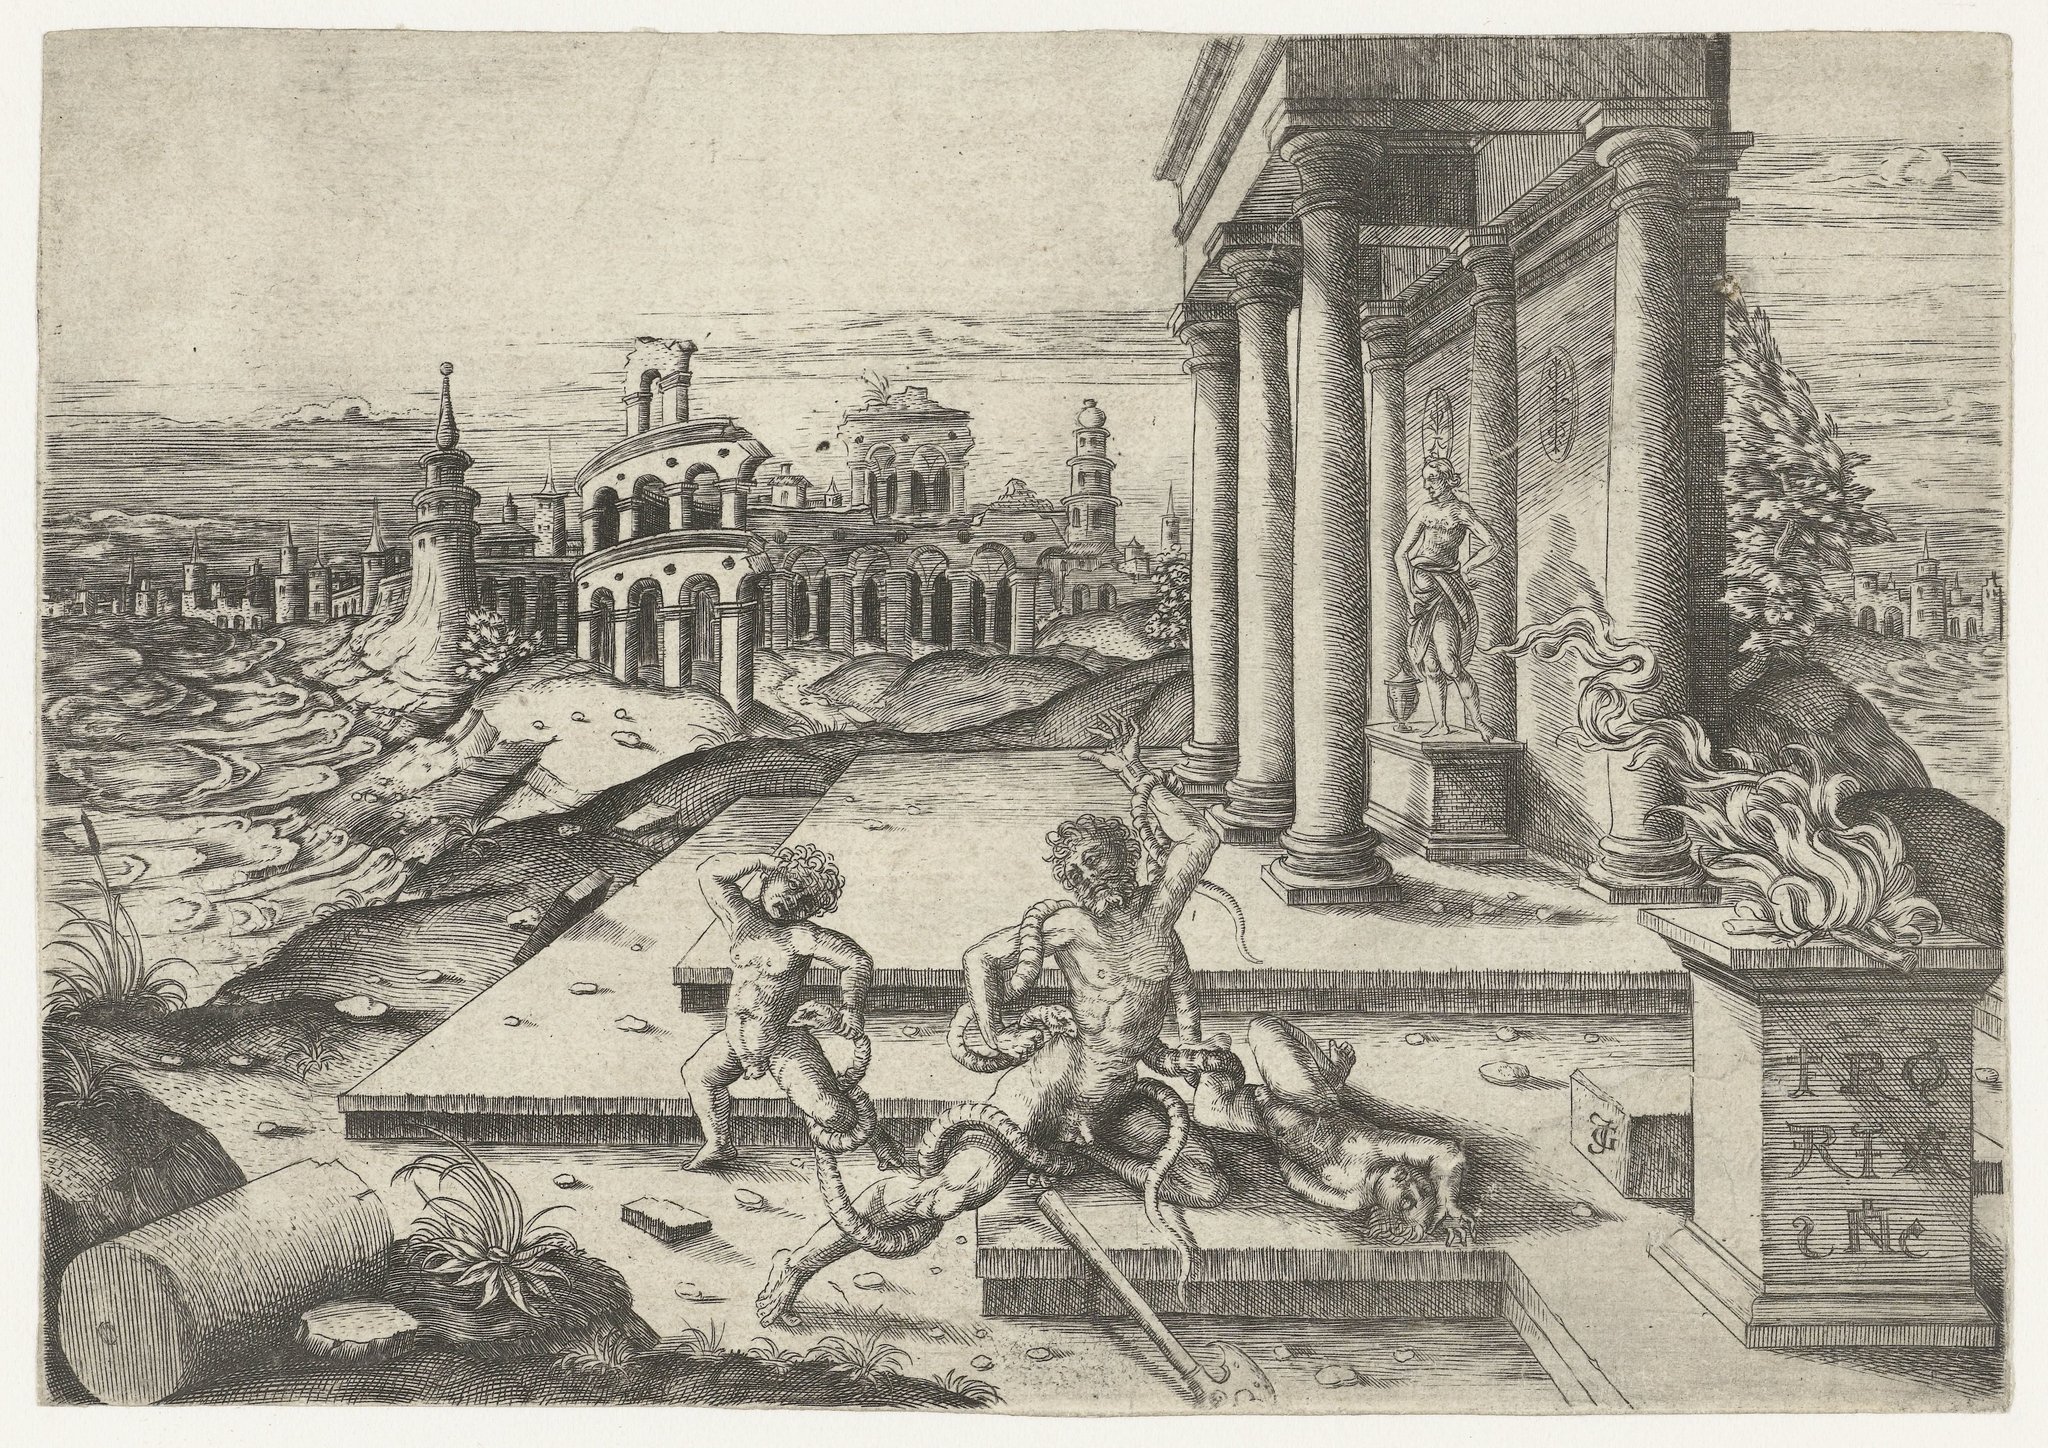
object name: print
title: Laocoön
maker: jean de gourmont (i)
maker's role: goldsmith, painter, print maker, publisher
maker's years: 1483-1557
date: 1493-1551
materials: paper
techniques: engraving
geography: france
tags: laocoon and his twin sons are strangled by two serpents during the preparations for a sacrifice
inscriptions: collector's mark: Lugt 2773, collector's mark: Lugt 2228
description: Laocoön en zijn twee zonen worden door twee zeeslangen omgebracht. Naast hen brandt een offervuur op een altaar, op de achtergrond een stad en ruïnes.